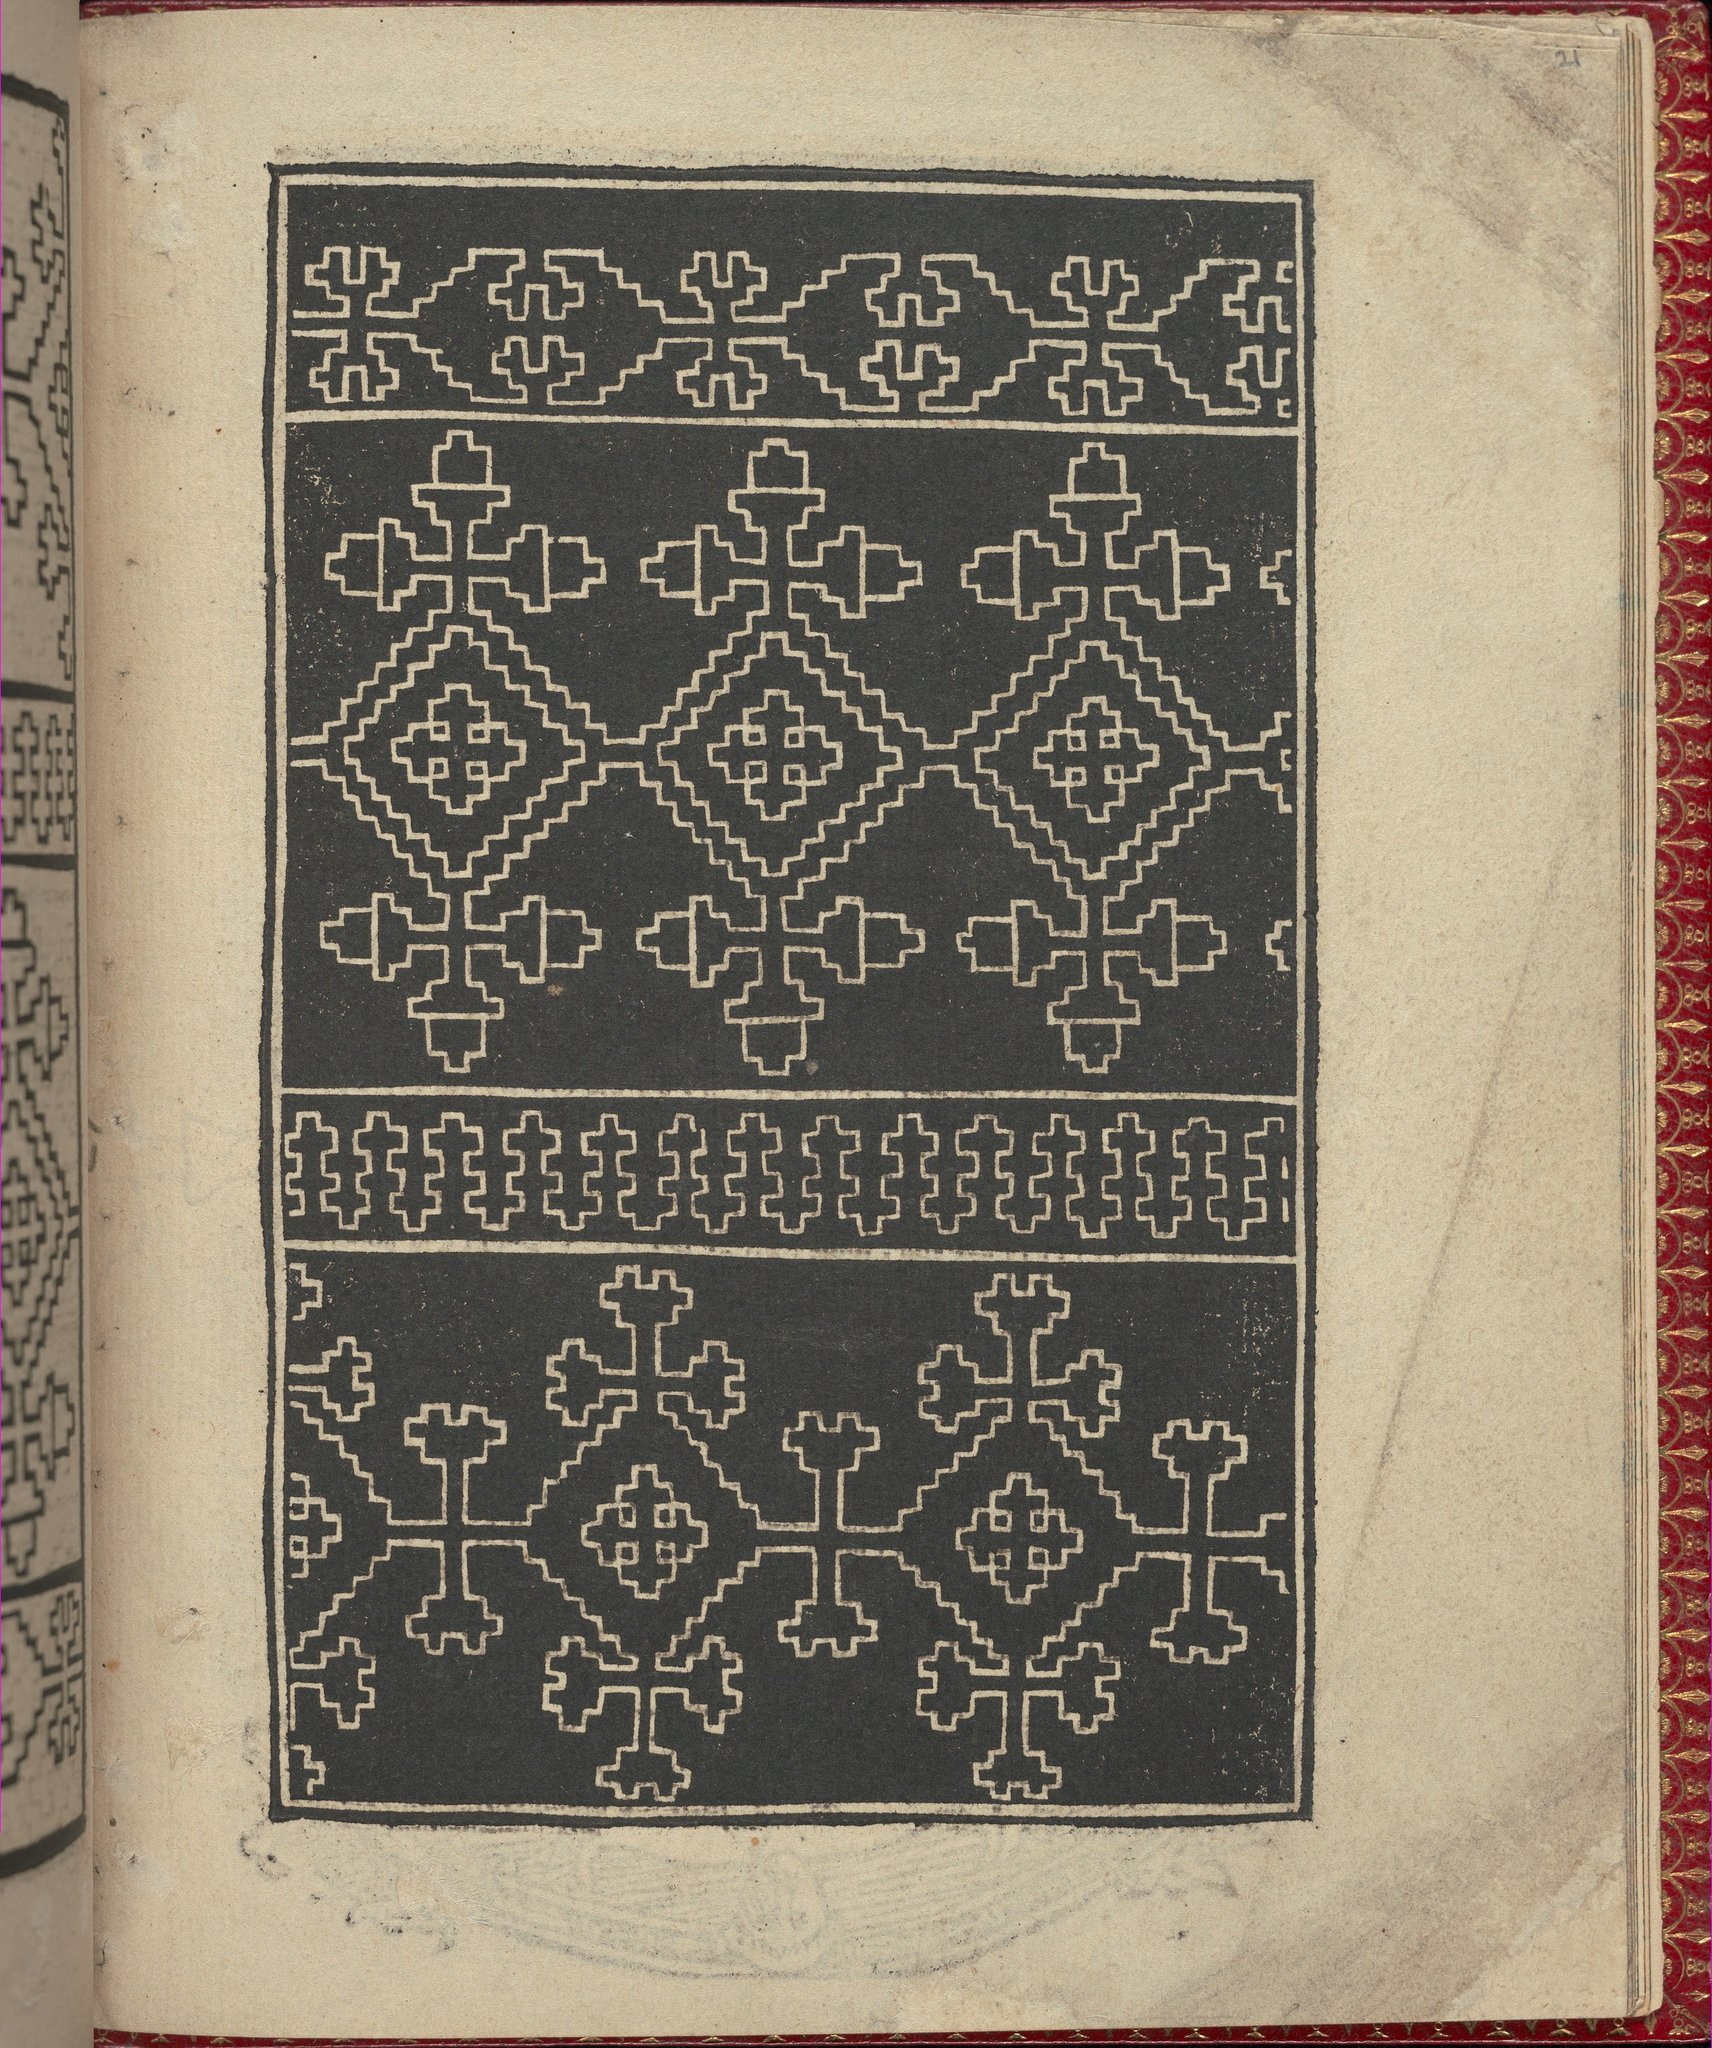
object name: book print ornament architecture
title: Ce est ung tractat de la noble art de leguille ascavoir ouvraiges de spaigne... page 21 (recto)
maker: willem vosterman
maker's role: printer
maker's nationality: netherlandish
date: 1527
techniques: woodcut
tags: ornament